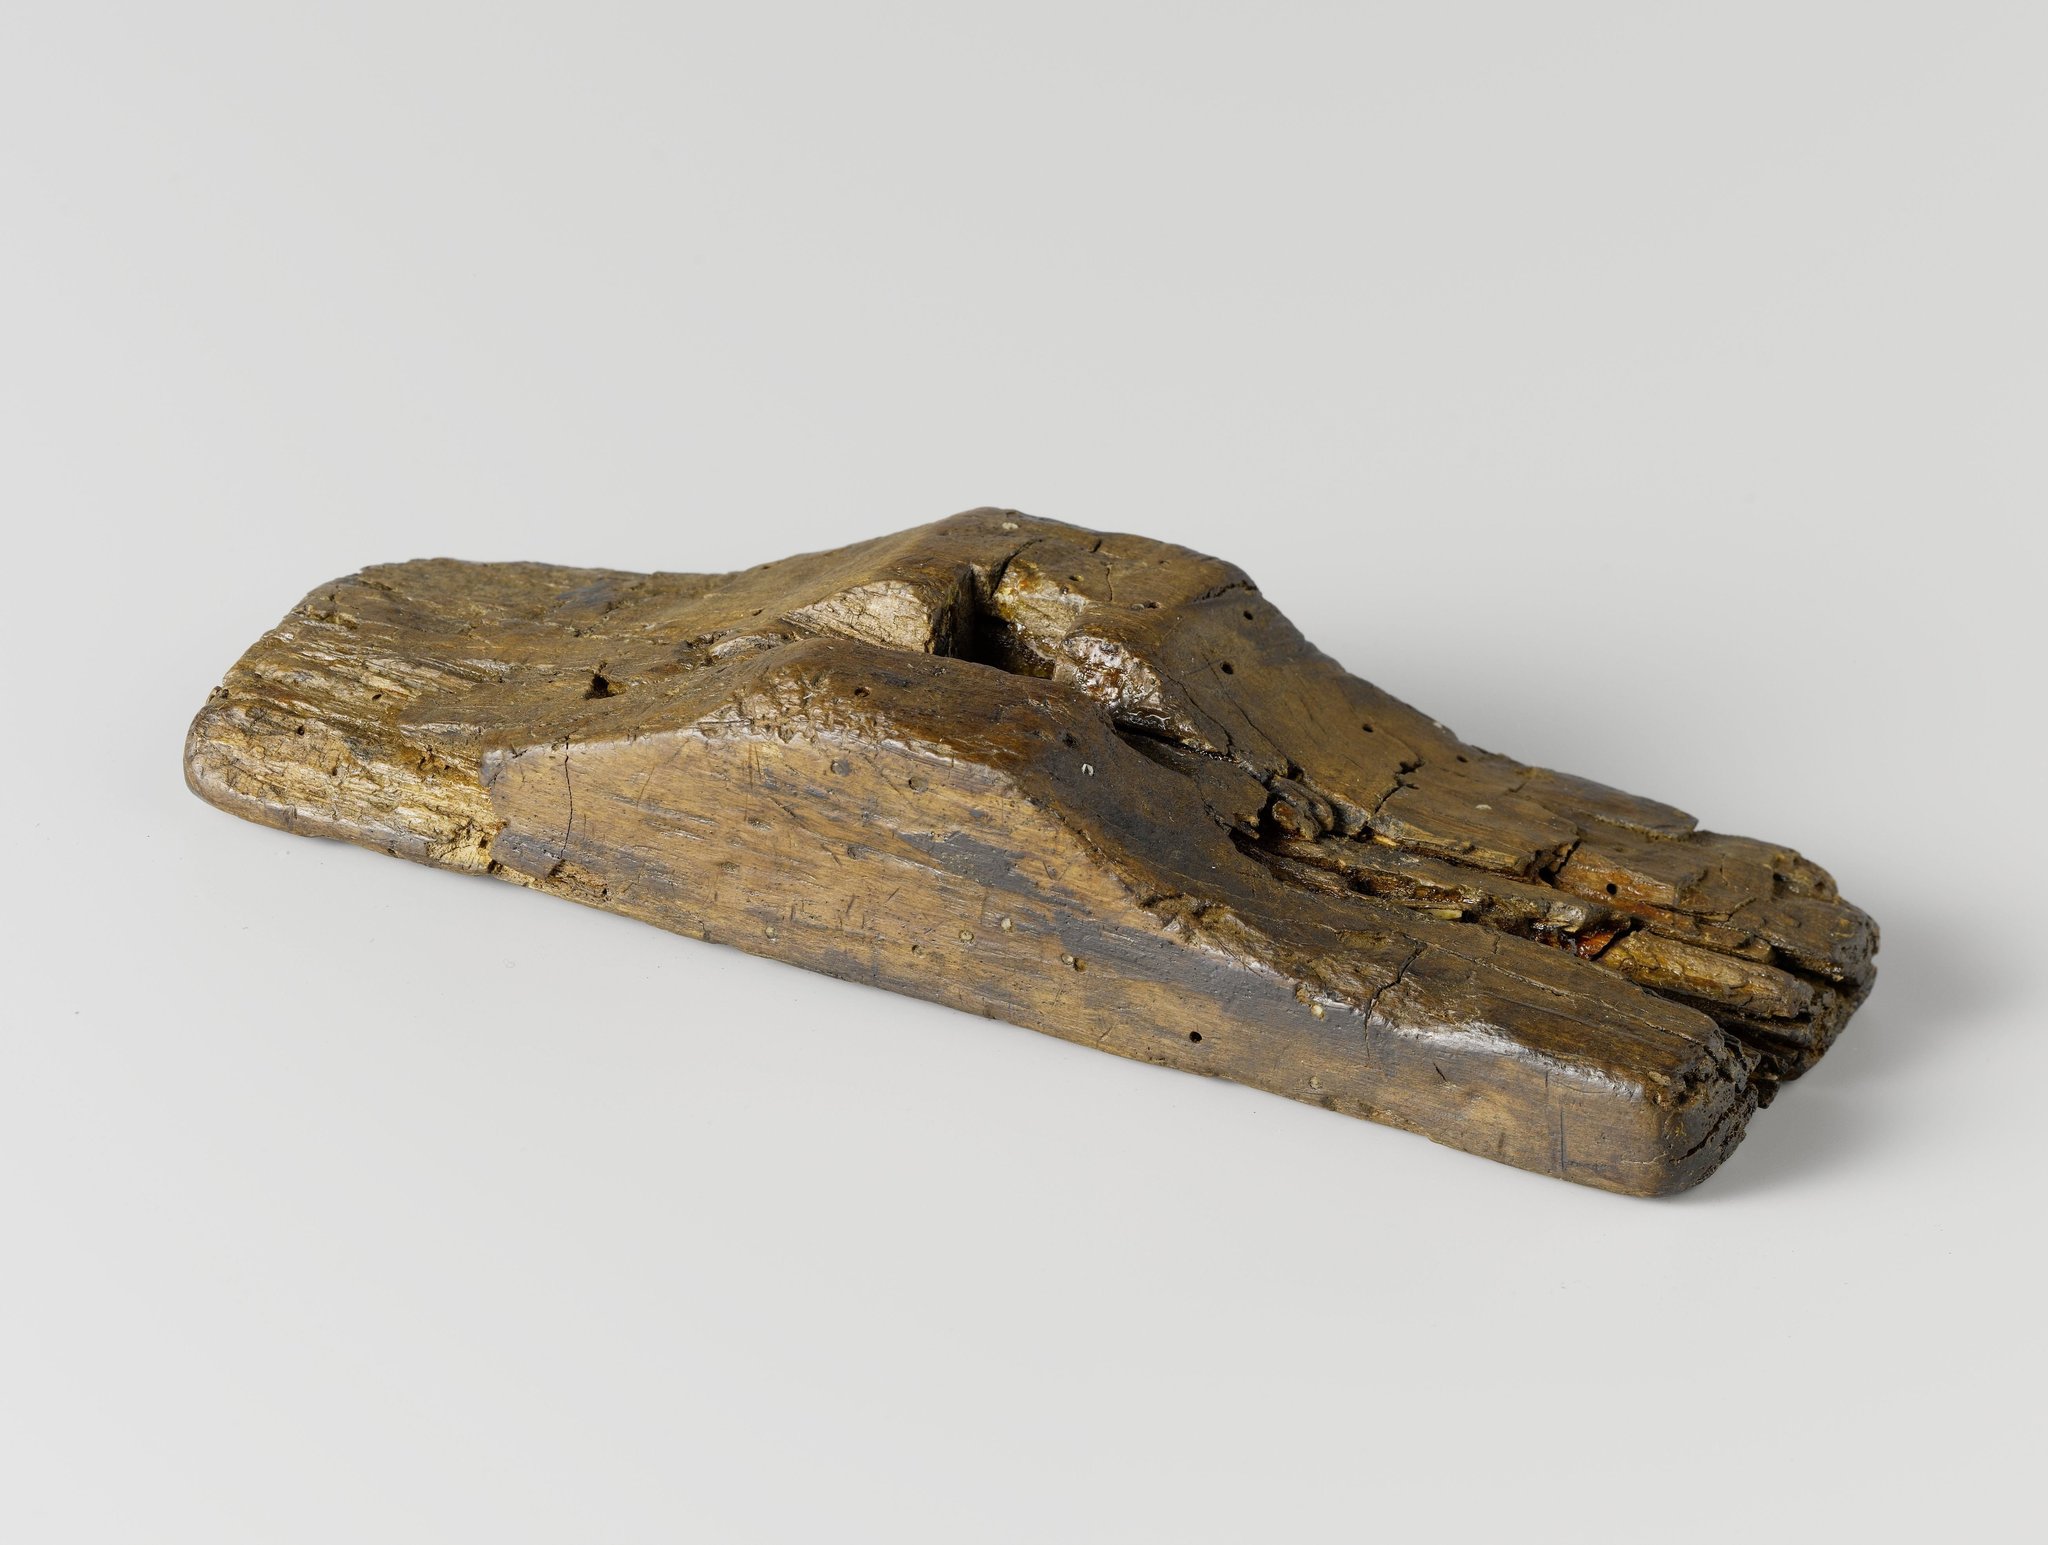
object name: cupboard turn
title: Wervel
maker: Anonymous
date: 1590-1596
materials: wood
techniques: cutting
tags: willem barendsz., amsterdam, jacob van heemskerck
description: Wervel in de vorm van een draaibare langwerpige houten klos met middenin een vierkant gat die dient om een deur of luik vast te zetten.